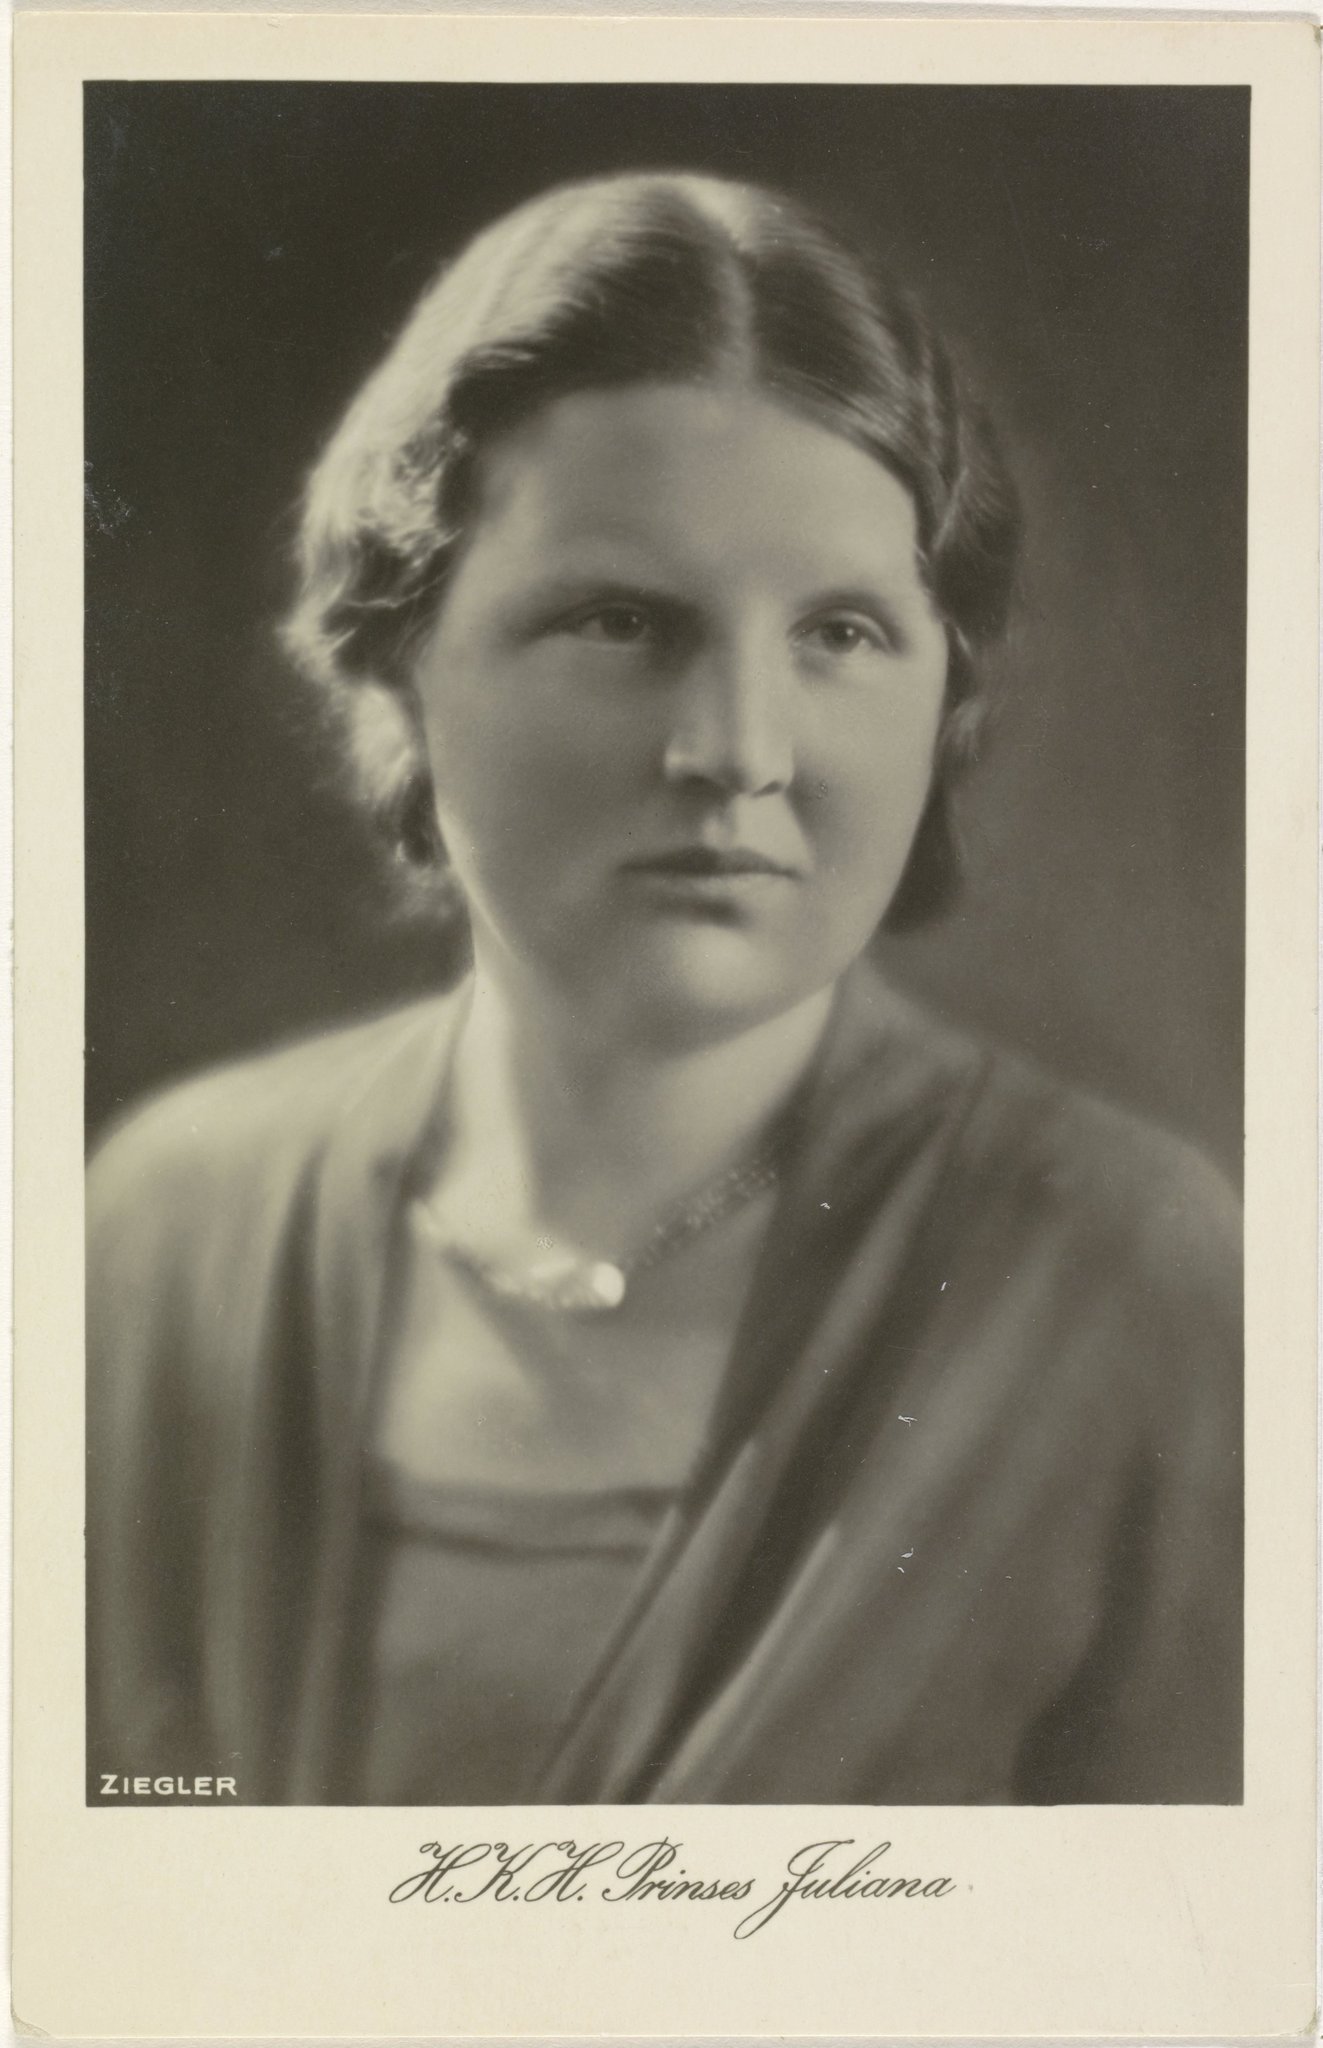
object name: photograph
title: Portret van Juliana, koningin der Nederlanden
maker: franz ziegler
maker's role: fotograaf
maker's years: 1893-1939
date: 1933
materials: photographic support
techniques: photography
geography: the hague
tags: the hague, juliana of the netherlands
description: De hier vermelde titel verwijst naar de hoogst verkregen titel van de geportretteerde, niet per se naar de titel die de geportretteerde op deze voorstelling draagt.